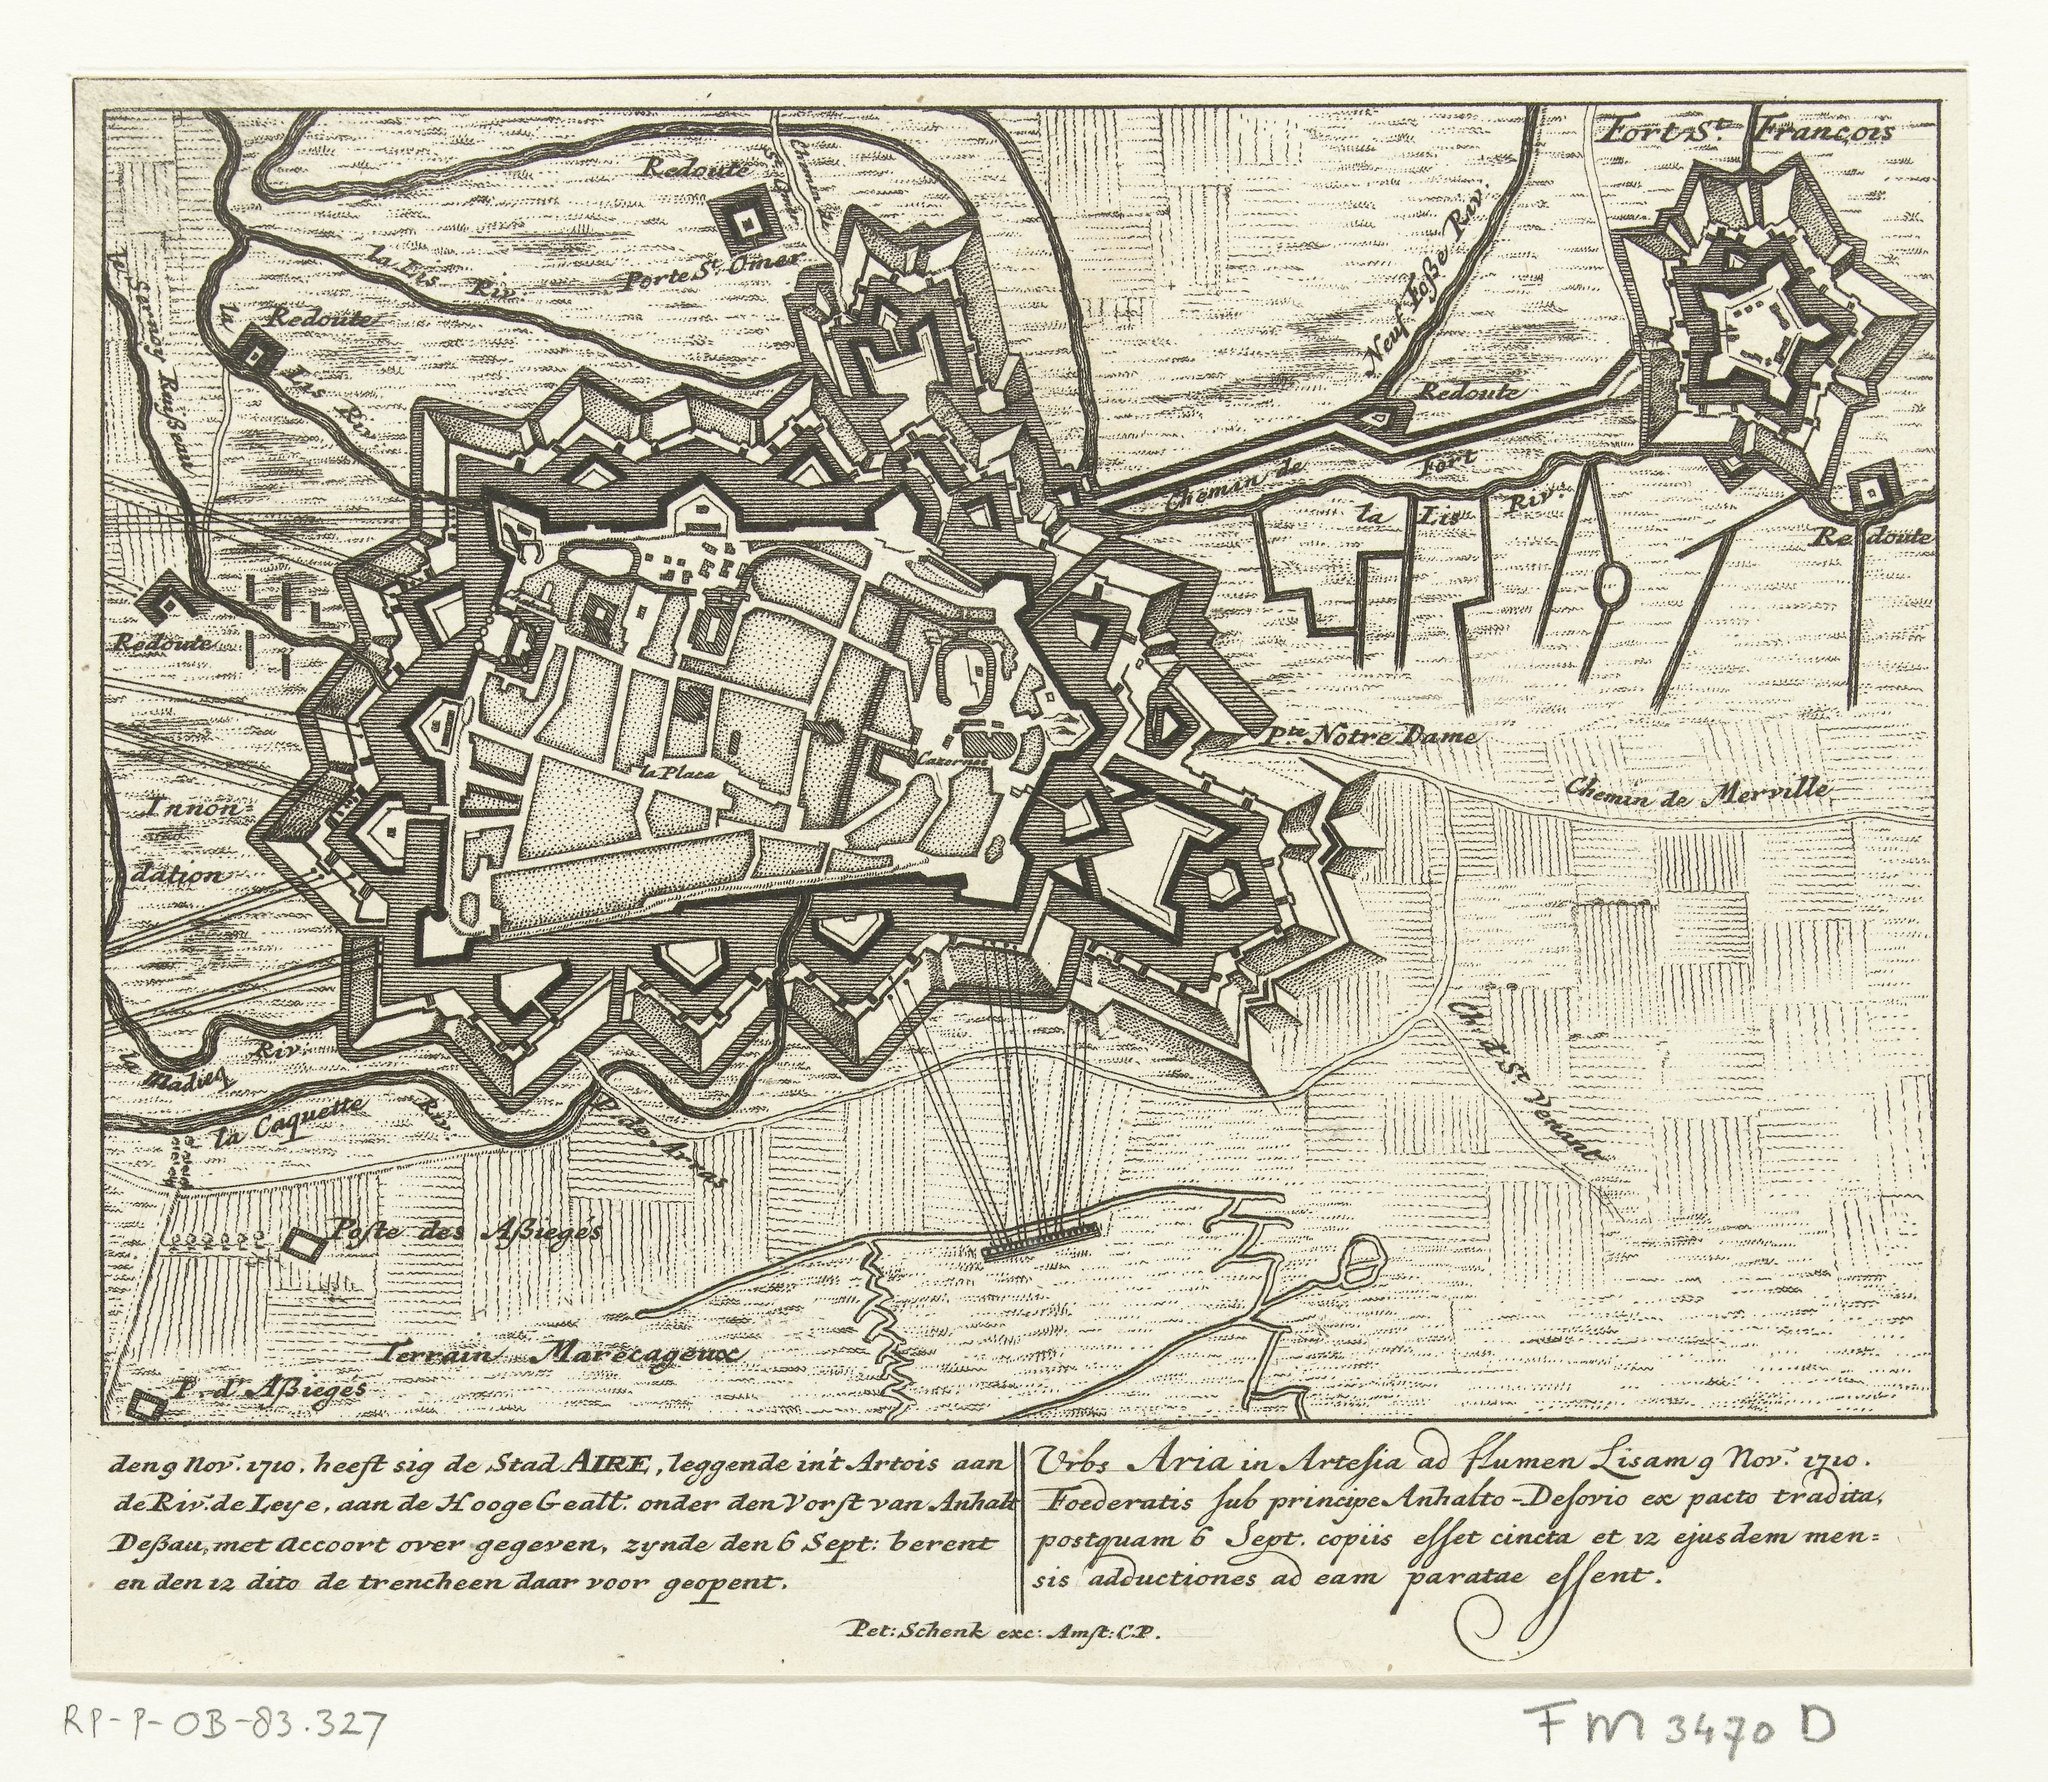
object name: print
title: Beleg van Aire, 1710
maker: pieter schenk (i)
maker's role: print maker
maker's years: 1660-1711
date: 1710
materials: paper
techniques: etching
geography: amsterdam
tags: siege, position war, maps of cities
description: Plattegrond van Aire, belegerd en ingenomen door de Geallieerden, 8 november 1710. Met onderschriften in het Nederlands en Latijn. Fragment van een grote plaat met negen voorstellingen van gebeurtenissen uit het jaar 1710 van de Spaanse Successieoorlog.